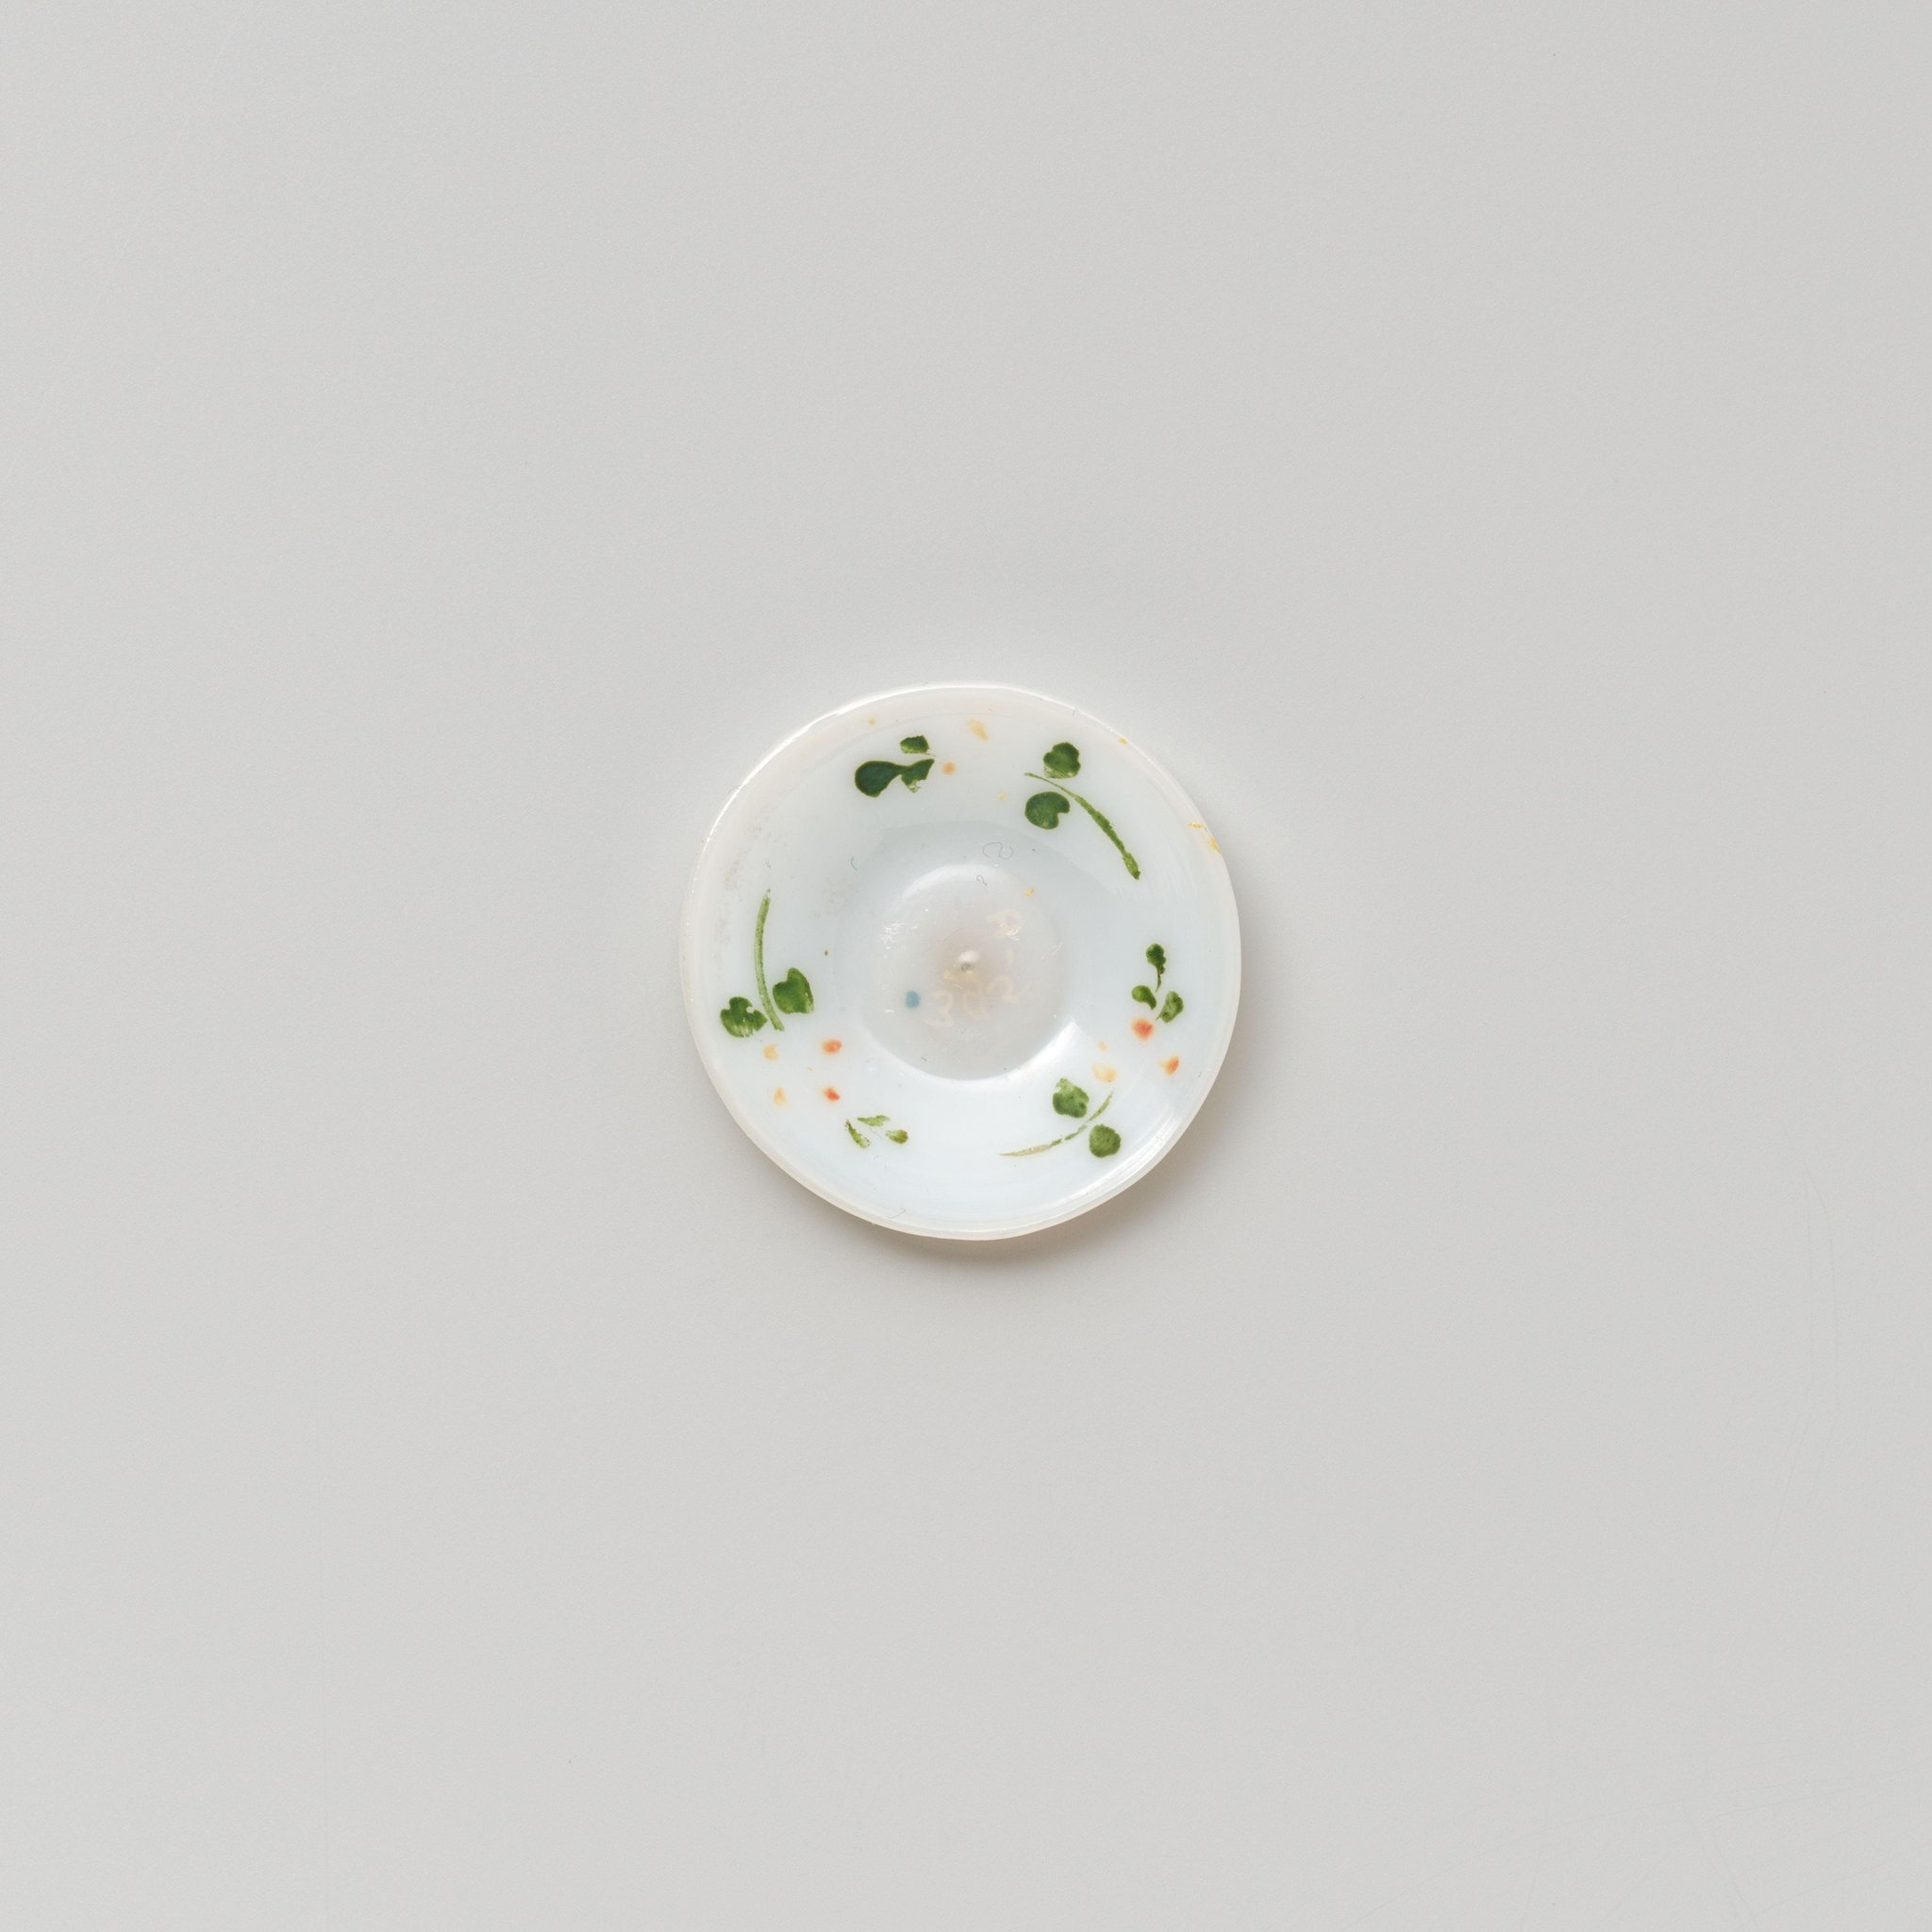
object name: platter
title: Schotel, beschilderd met bloemen in wit, groen en rood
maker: Anonymous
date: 1800-1849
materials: glass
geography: bristol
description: Schotel van opaak wit glas, met brede schuin opstaande rand, beschilderd met bloemenin wit, groen en rood.